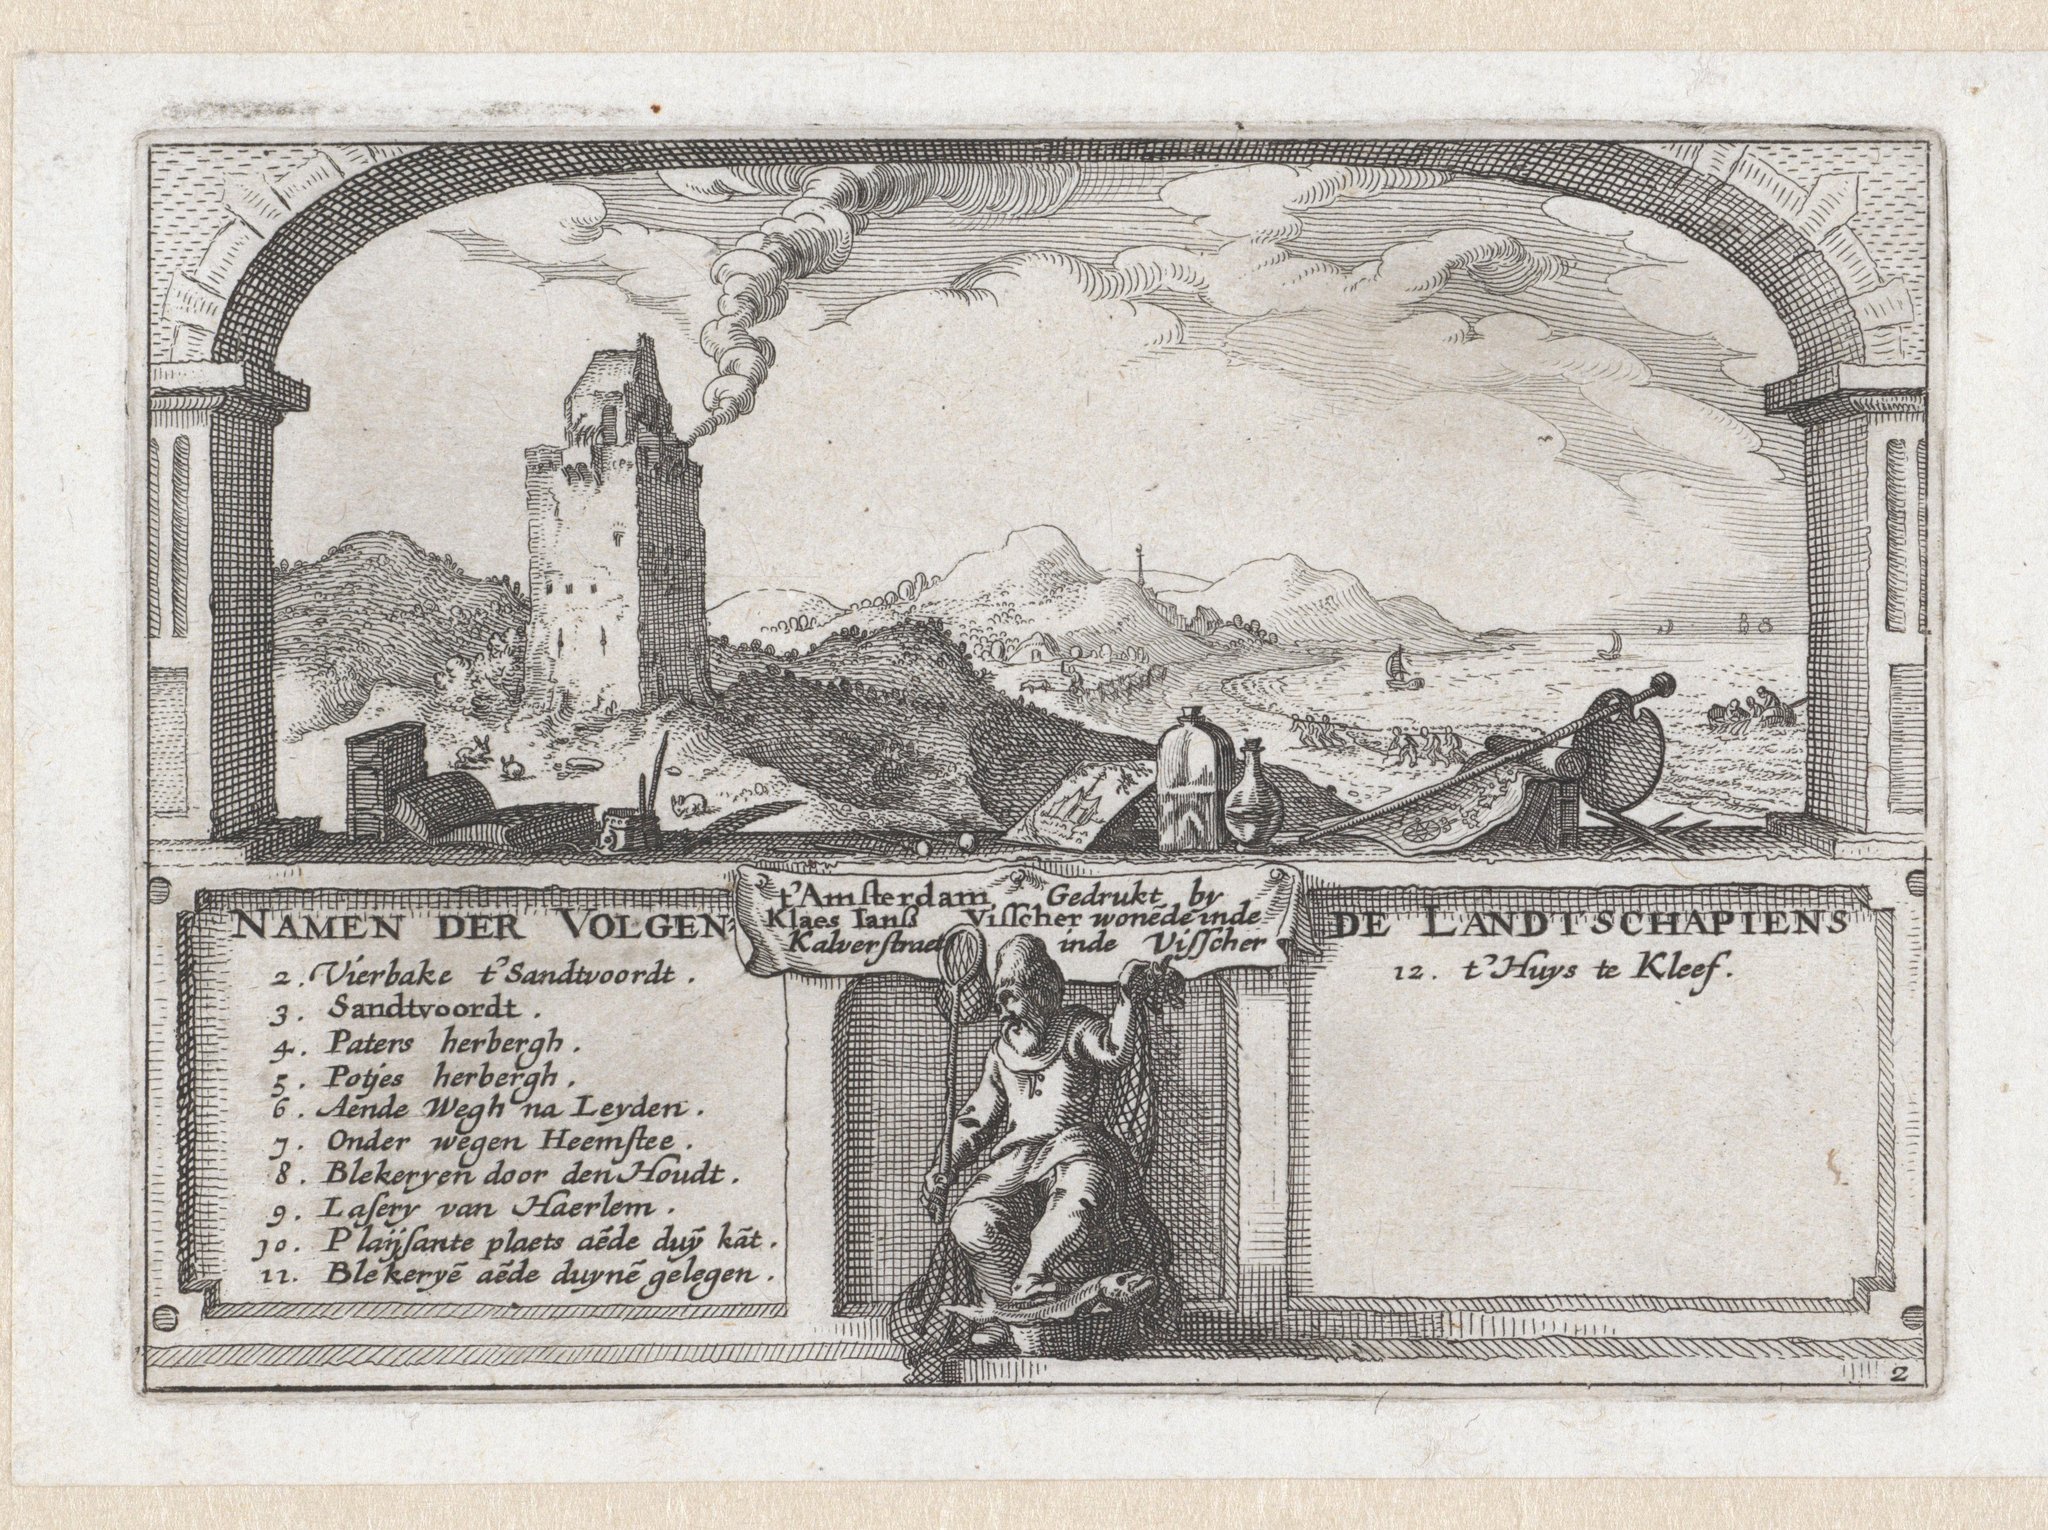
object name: titelprent, frontispice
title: The Lighthouse at Zandvoort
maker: claes jansz. visscher (ii)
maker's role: draughtsman, print maker, publisher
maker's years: 1586-1652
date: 1611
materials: paper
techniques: engraving, etching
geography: amsterdam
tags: lighthouse, lightship, fisherman, rodents: rabbit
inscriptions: inscription: ‘NAMEN DER VOLGENDE LANTSCHAPIENS 2-12’, caption: ‘1.Vierbake t' Sandtvoordt ...12. t' Huys te Kleef’, address: ‘t' Amsterdam Gedrukt by Klaes Ianss Visscher wonede inde Kalverstraet inde Visscher’, collector's mark: Lugt 2228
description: Door een boogvormig venster de vuurtoren van Zantvoort te zien. Op de voorgrond boek- en drukkersattributen. Daaronder, in kader op de 'stenen muur' in het midden een visser,zittend onderhet adres van Claes Jansz. Visscher.: t' Amsterdam Gedrukt by Klaes IanssVisscherwonede inde Kalverstraet inde Visscher.Links en rechts de nummers en namen van de topografische plaatsen die in de serie zijn afgebeeld in de serie NAMEN DERVOLGENDELANTSCHAPIENS 2-12